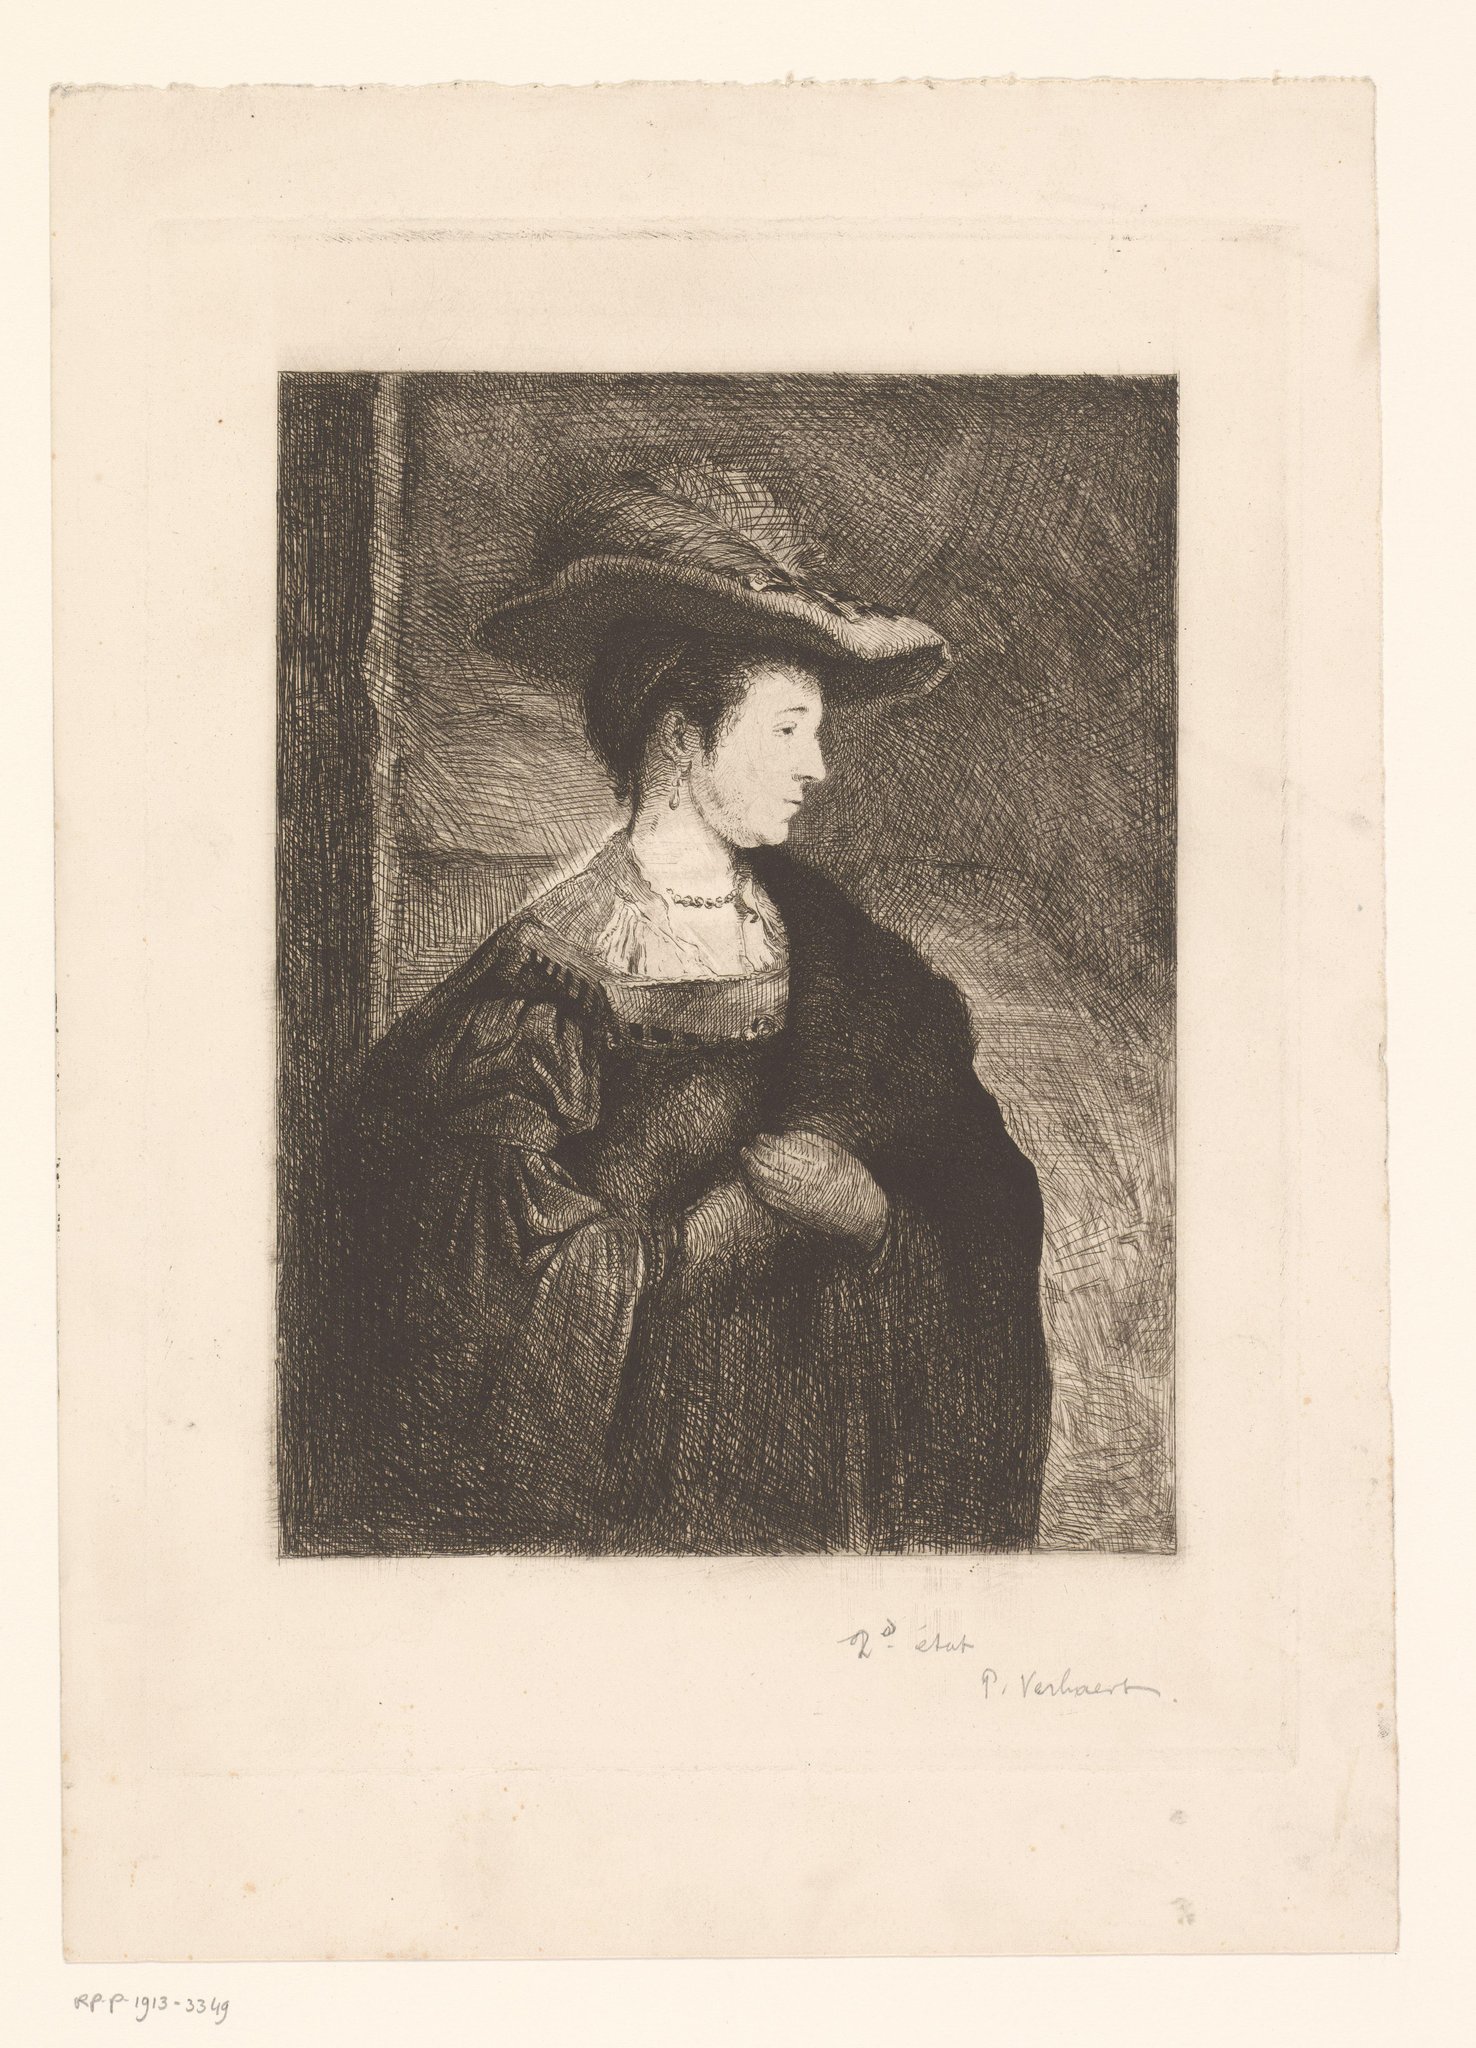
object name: print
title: Portret van Saskia van Uylenburgh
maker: piet verhaert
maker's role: print maker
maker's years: 1852-1908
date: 1884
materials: paper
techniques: etching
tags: amsterdam, adult woman, historical persons, head-gear: hat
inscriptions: collector's mark: Lugt 2228, inscription: ‘2e état’